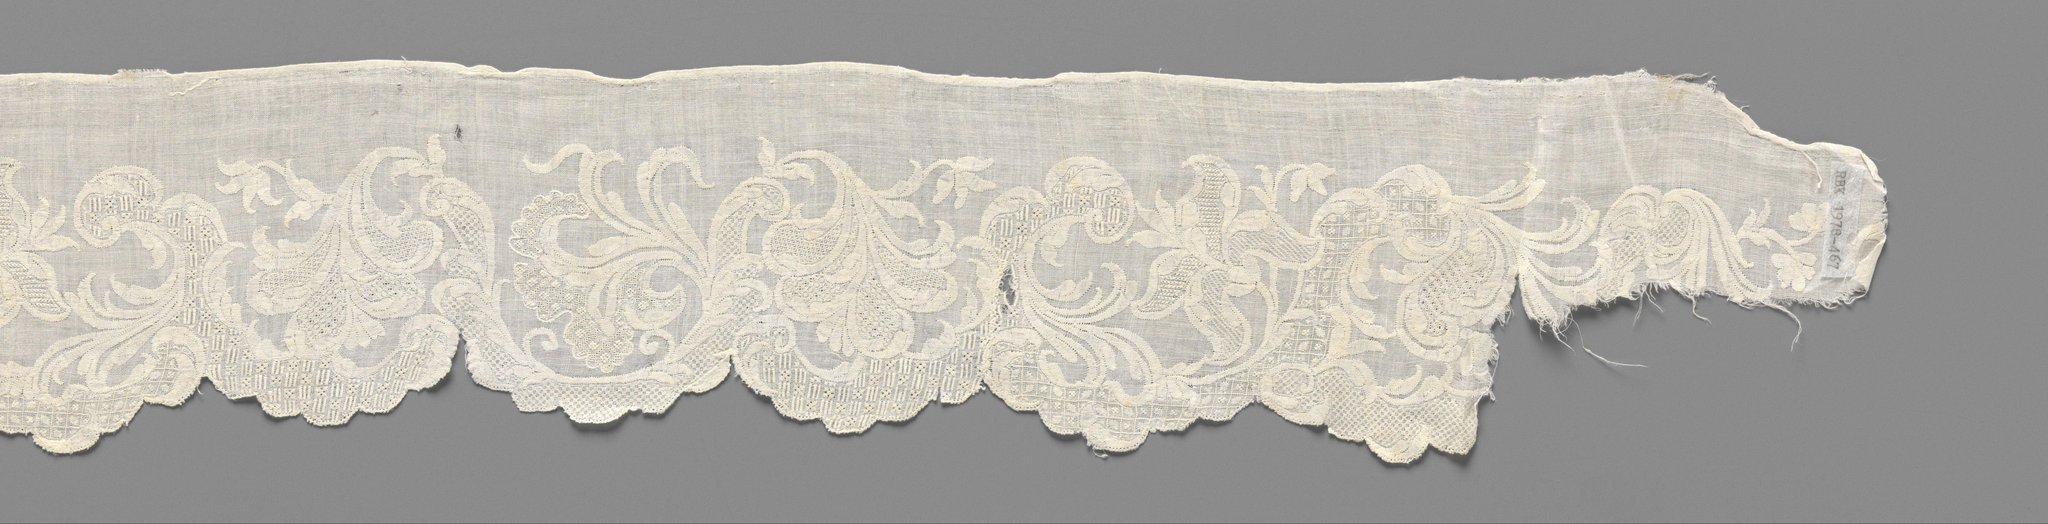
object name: engageante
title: Engageante van batist met borduurwerk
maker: Anonymous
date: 1740-1770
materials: textile, cotton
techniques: embroidered, shadow quilted, weave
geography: dresden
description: Engageante van naturelkleurig batist met borduurwerk. Het patroon heeft een naar links golvende voluutbloem in een rocailleschulp die het midden vormt tussen voluutranken, waaraan symmetrische waaiervormige en telkens gevarieerde bloemen in elke schulp staan, waarvan de randen uit rasterwerk-rocailles bestaan. Het borduurwerk bestaat onder andere uit schaduwwerk, werk met uitgetrokken draden en tamboereerwerk.